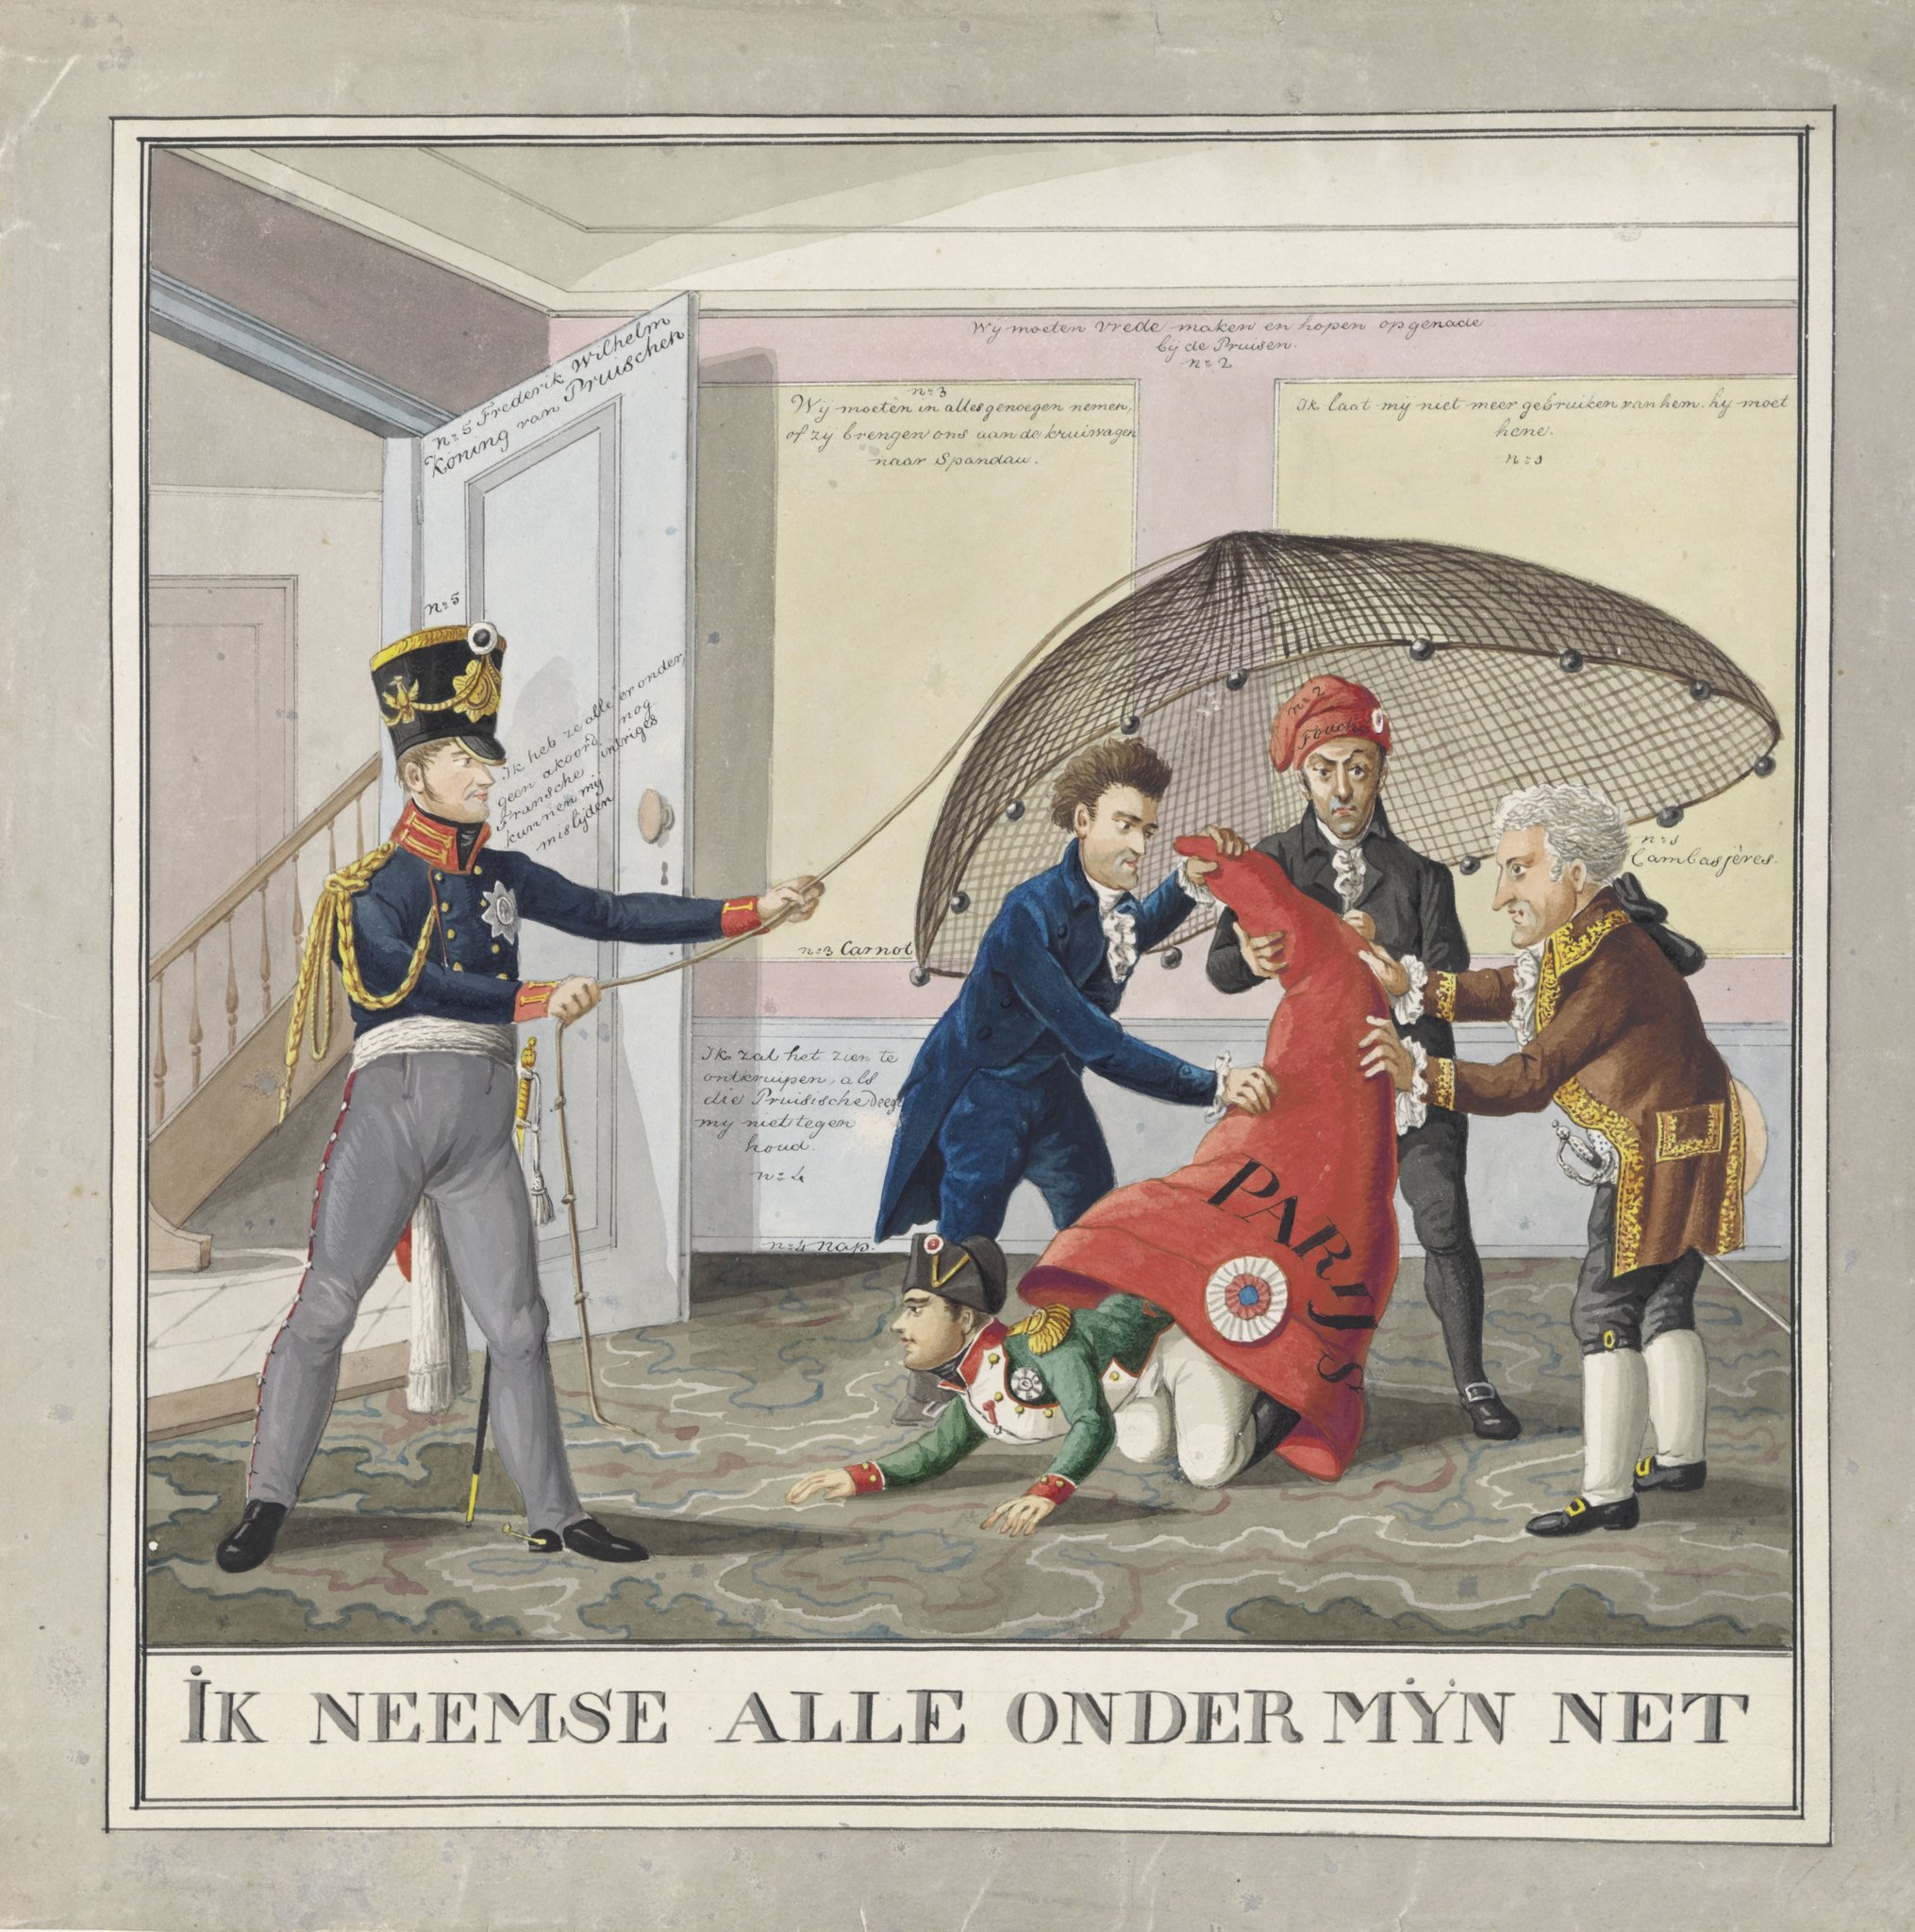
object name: drawing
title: Ik neemse alle onder mijn net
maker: wijnand esser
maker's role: draughtsman, print maker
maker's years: 1779-1860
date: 1815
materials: paper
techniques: brush, pen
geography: netherlands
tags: napoleon i (emperor of the french), berlin, frederik willem iii koning van pruisen, head-gear: cap, catching animals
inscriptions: collector's mark: Lugt 2228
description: Napoleon probeert zich na zijn terugkeer in Parijs in juni 1815 tevergeefs te verschuilen in een grote Jacobijnenmuts, getekend 'Parijs'. Hij wordt echter uit de muts geschud door Carnot, Fouché en Cambacérès. Links de koning van Pruisen die met een groot valnet het hele stel vangt. De personen genummerd 1-5.